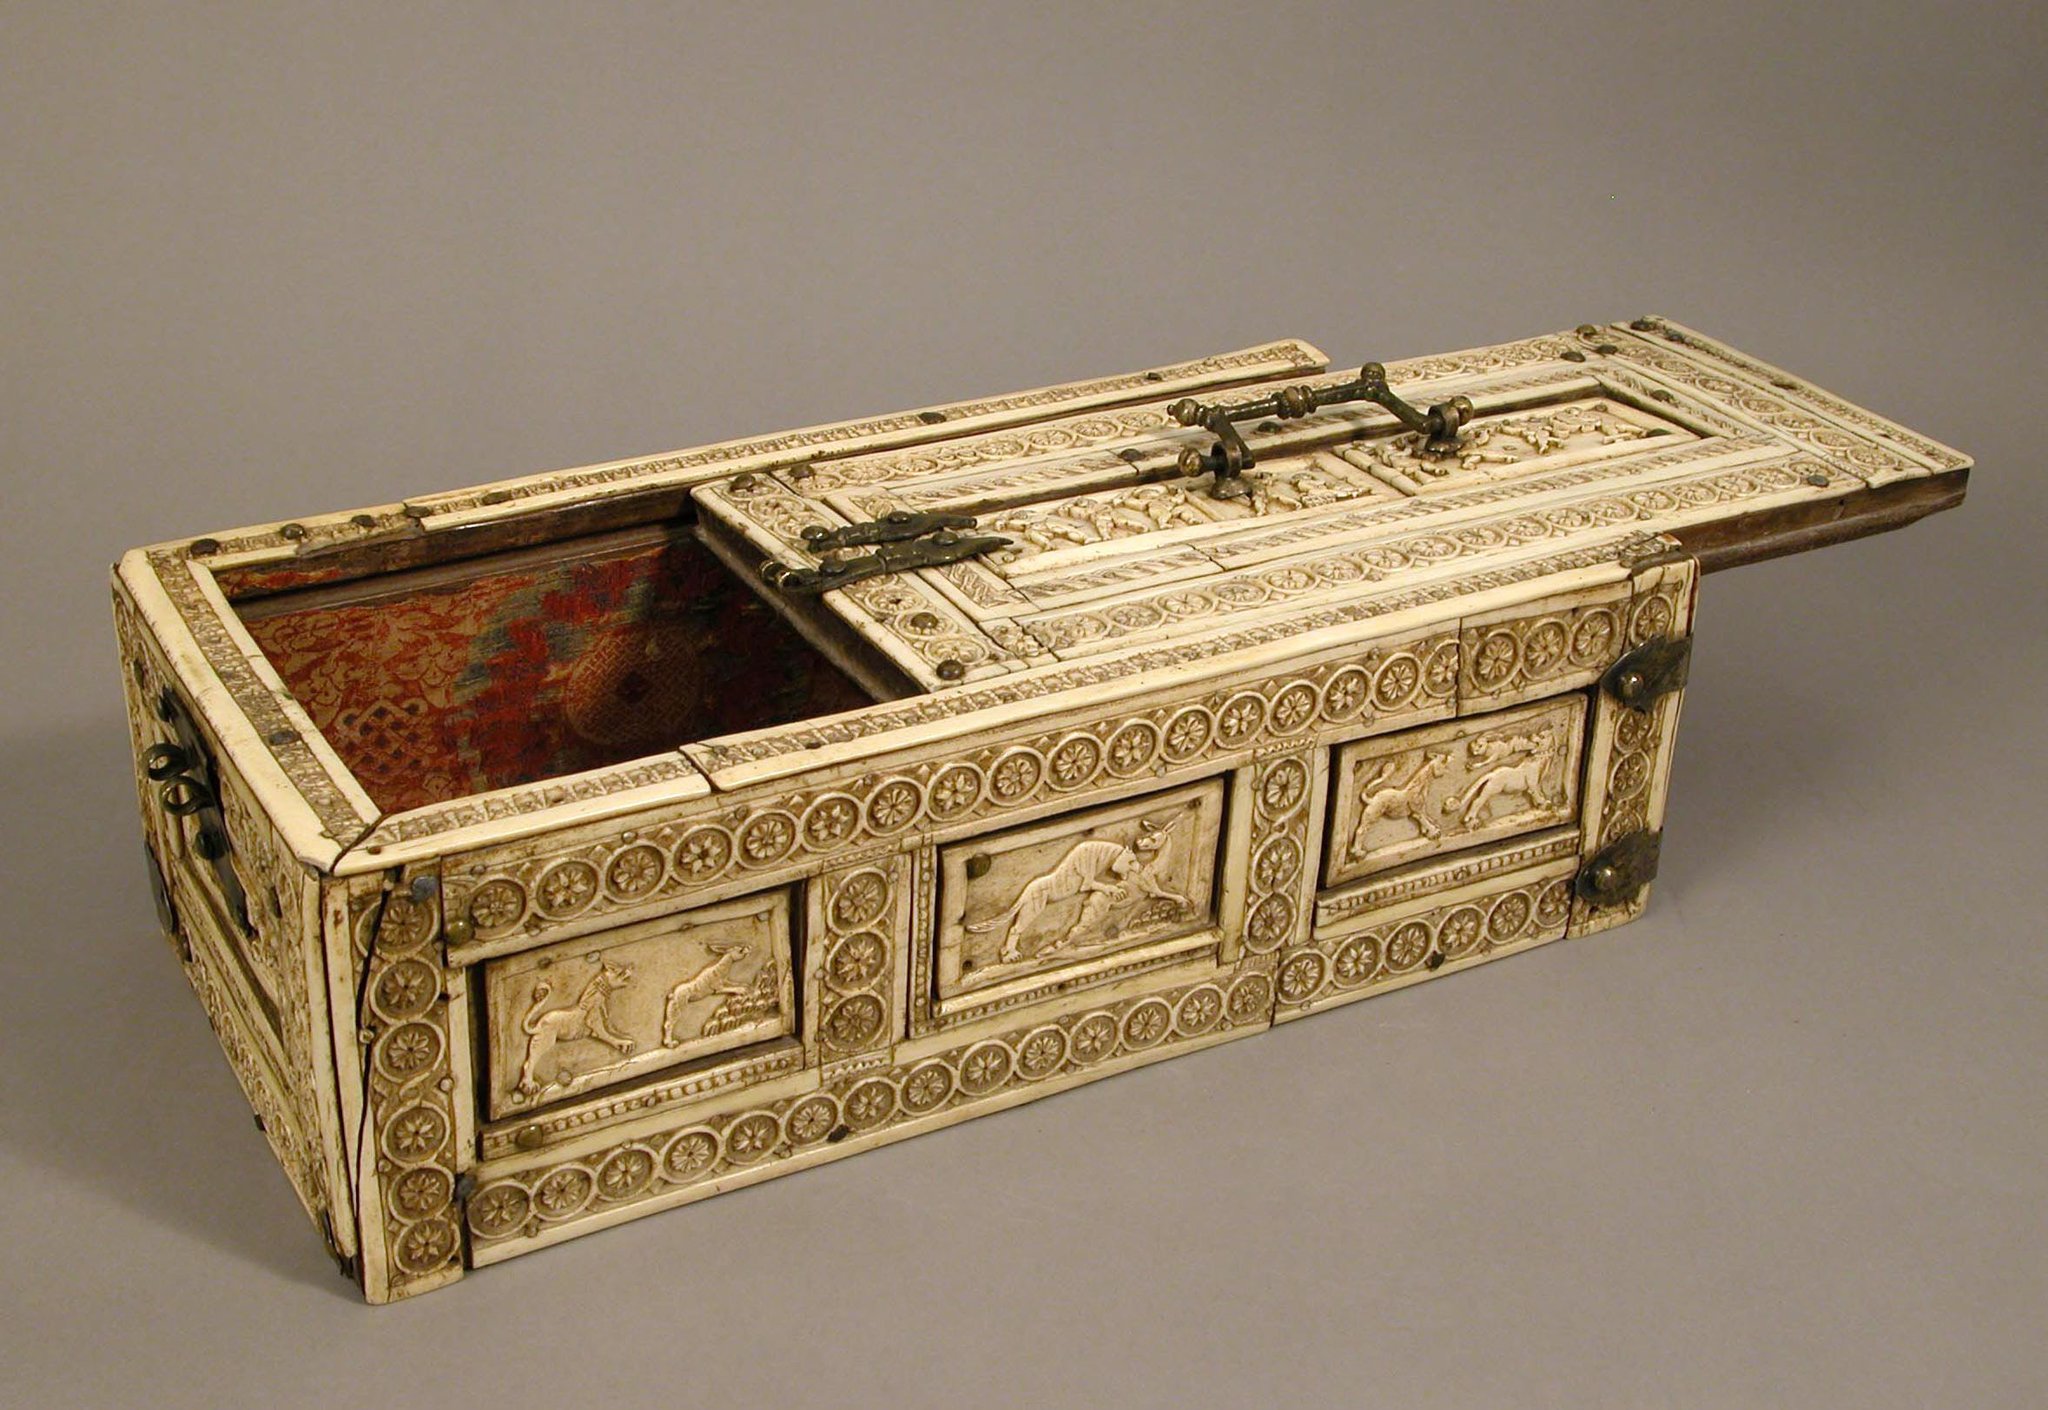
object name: casket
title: Casket with Erotes and Animals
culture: byzantine or italian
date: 1101-1200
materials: bone, copper, silk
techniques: lining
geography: adriatic sea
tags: animals,children,musicians